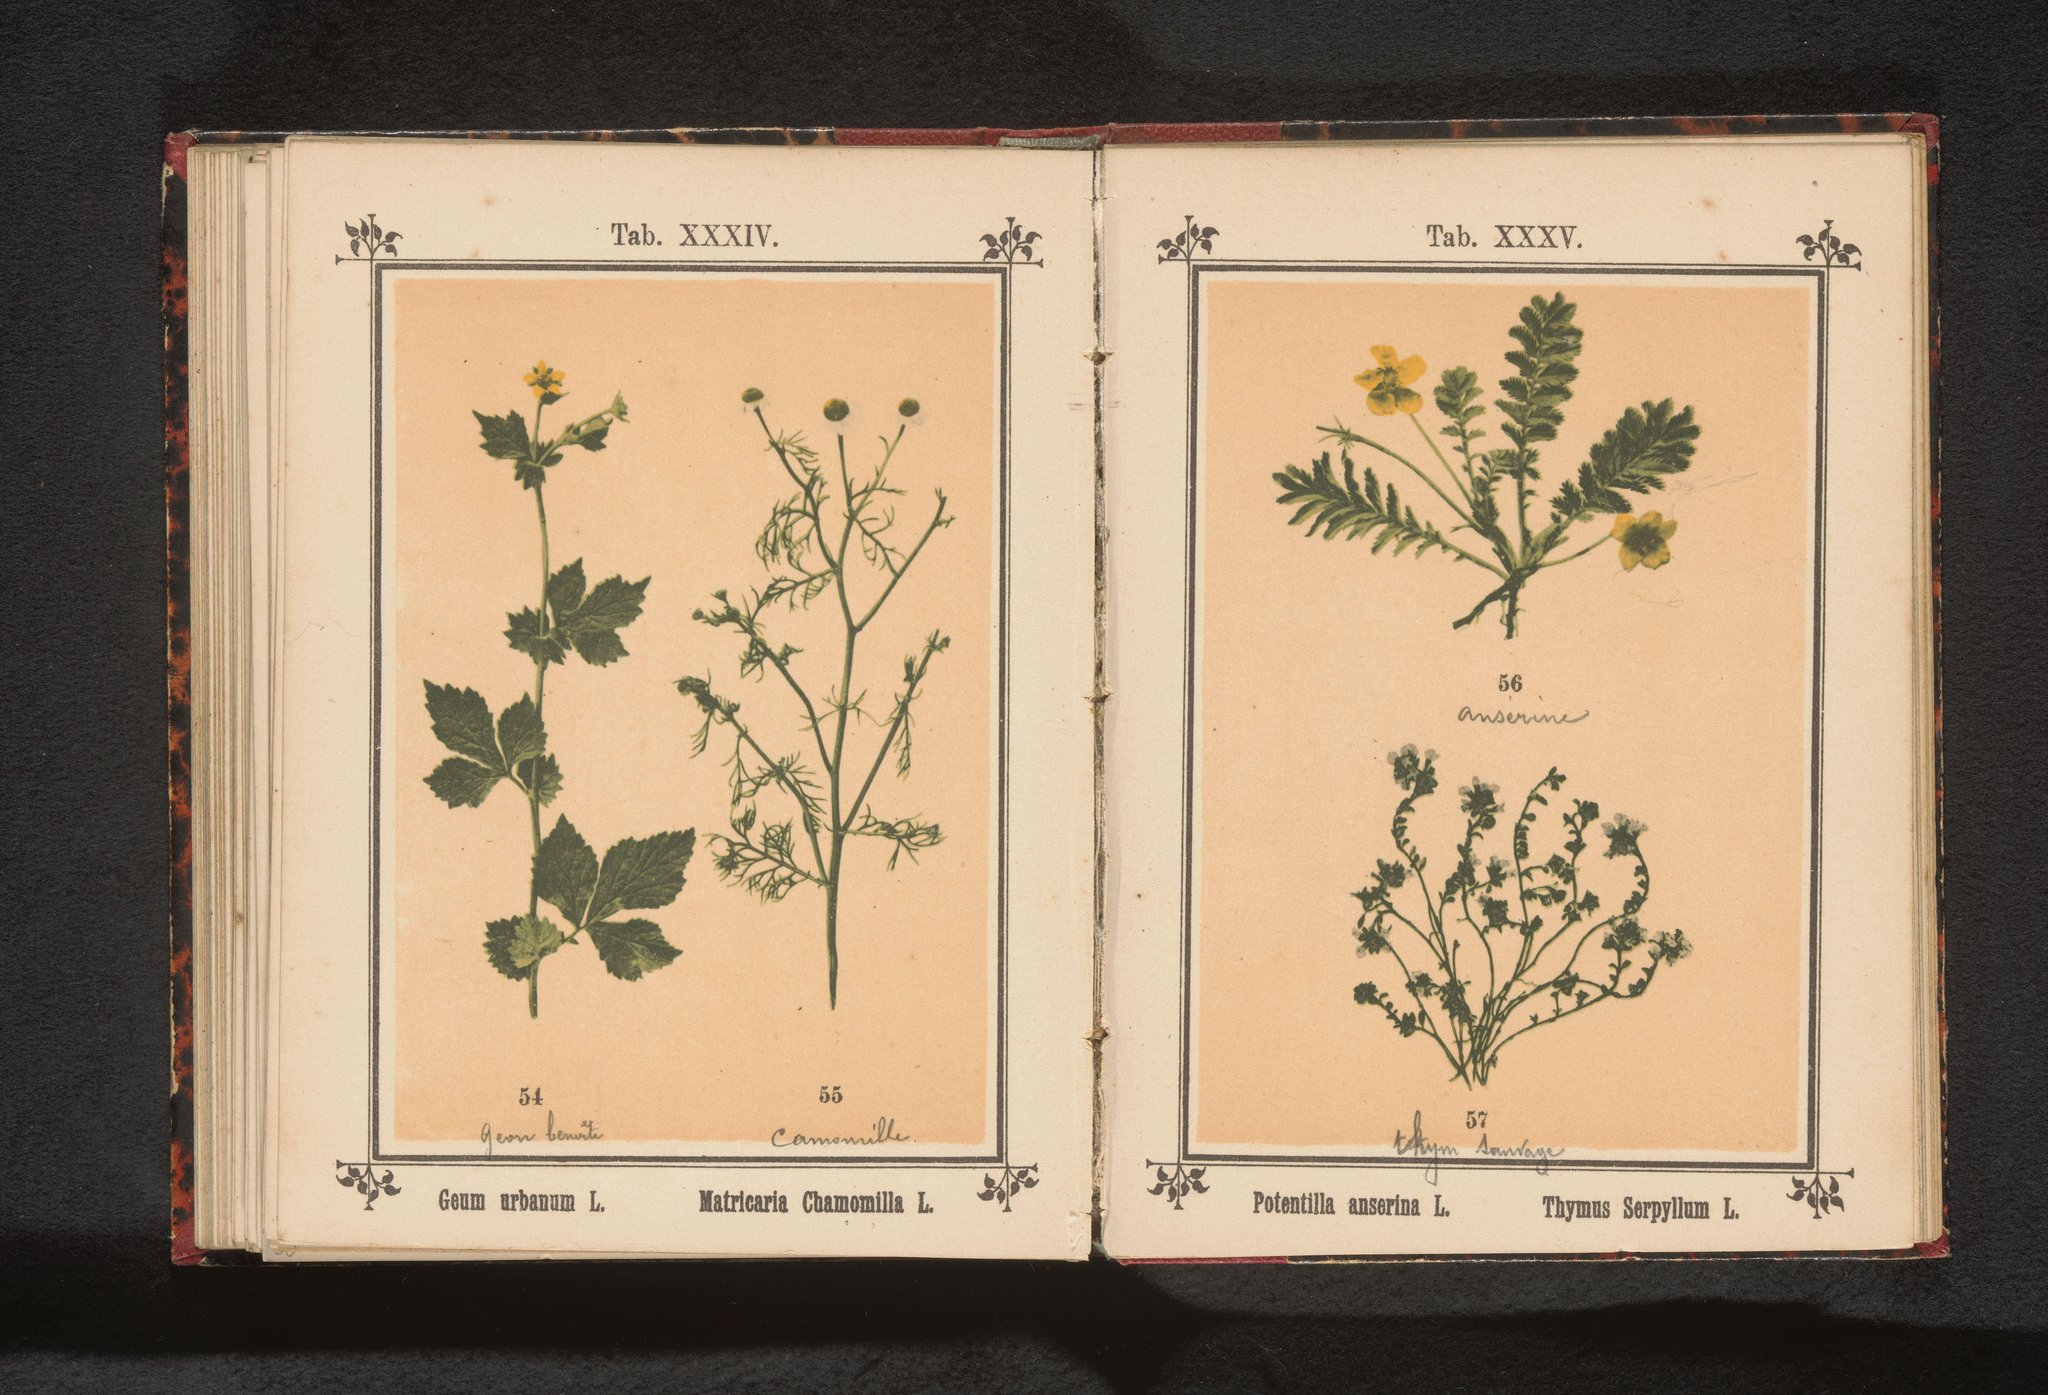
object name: photomechanical print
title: Geel nagelkruid en echte kamille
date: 1884-1894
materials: paper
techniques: photograph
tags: plants (in general)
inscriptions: number: ‘Tab. XXXIV.’, inscription: ‘geon benoite camomille’